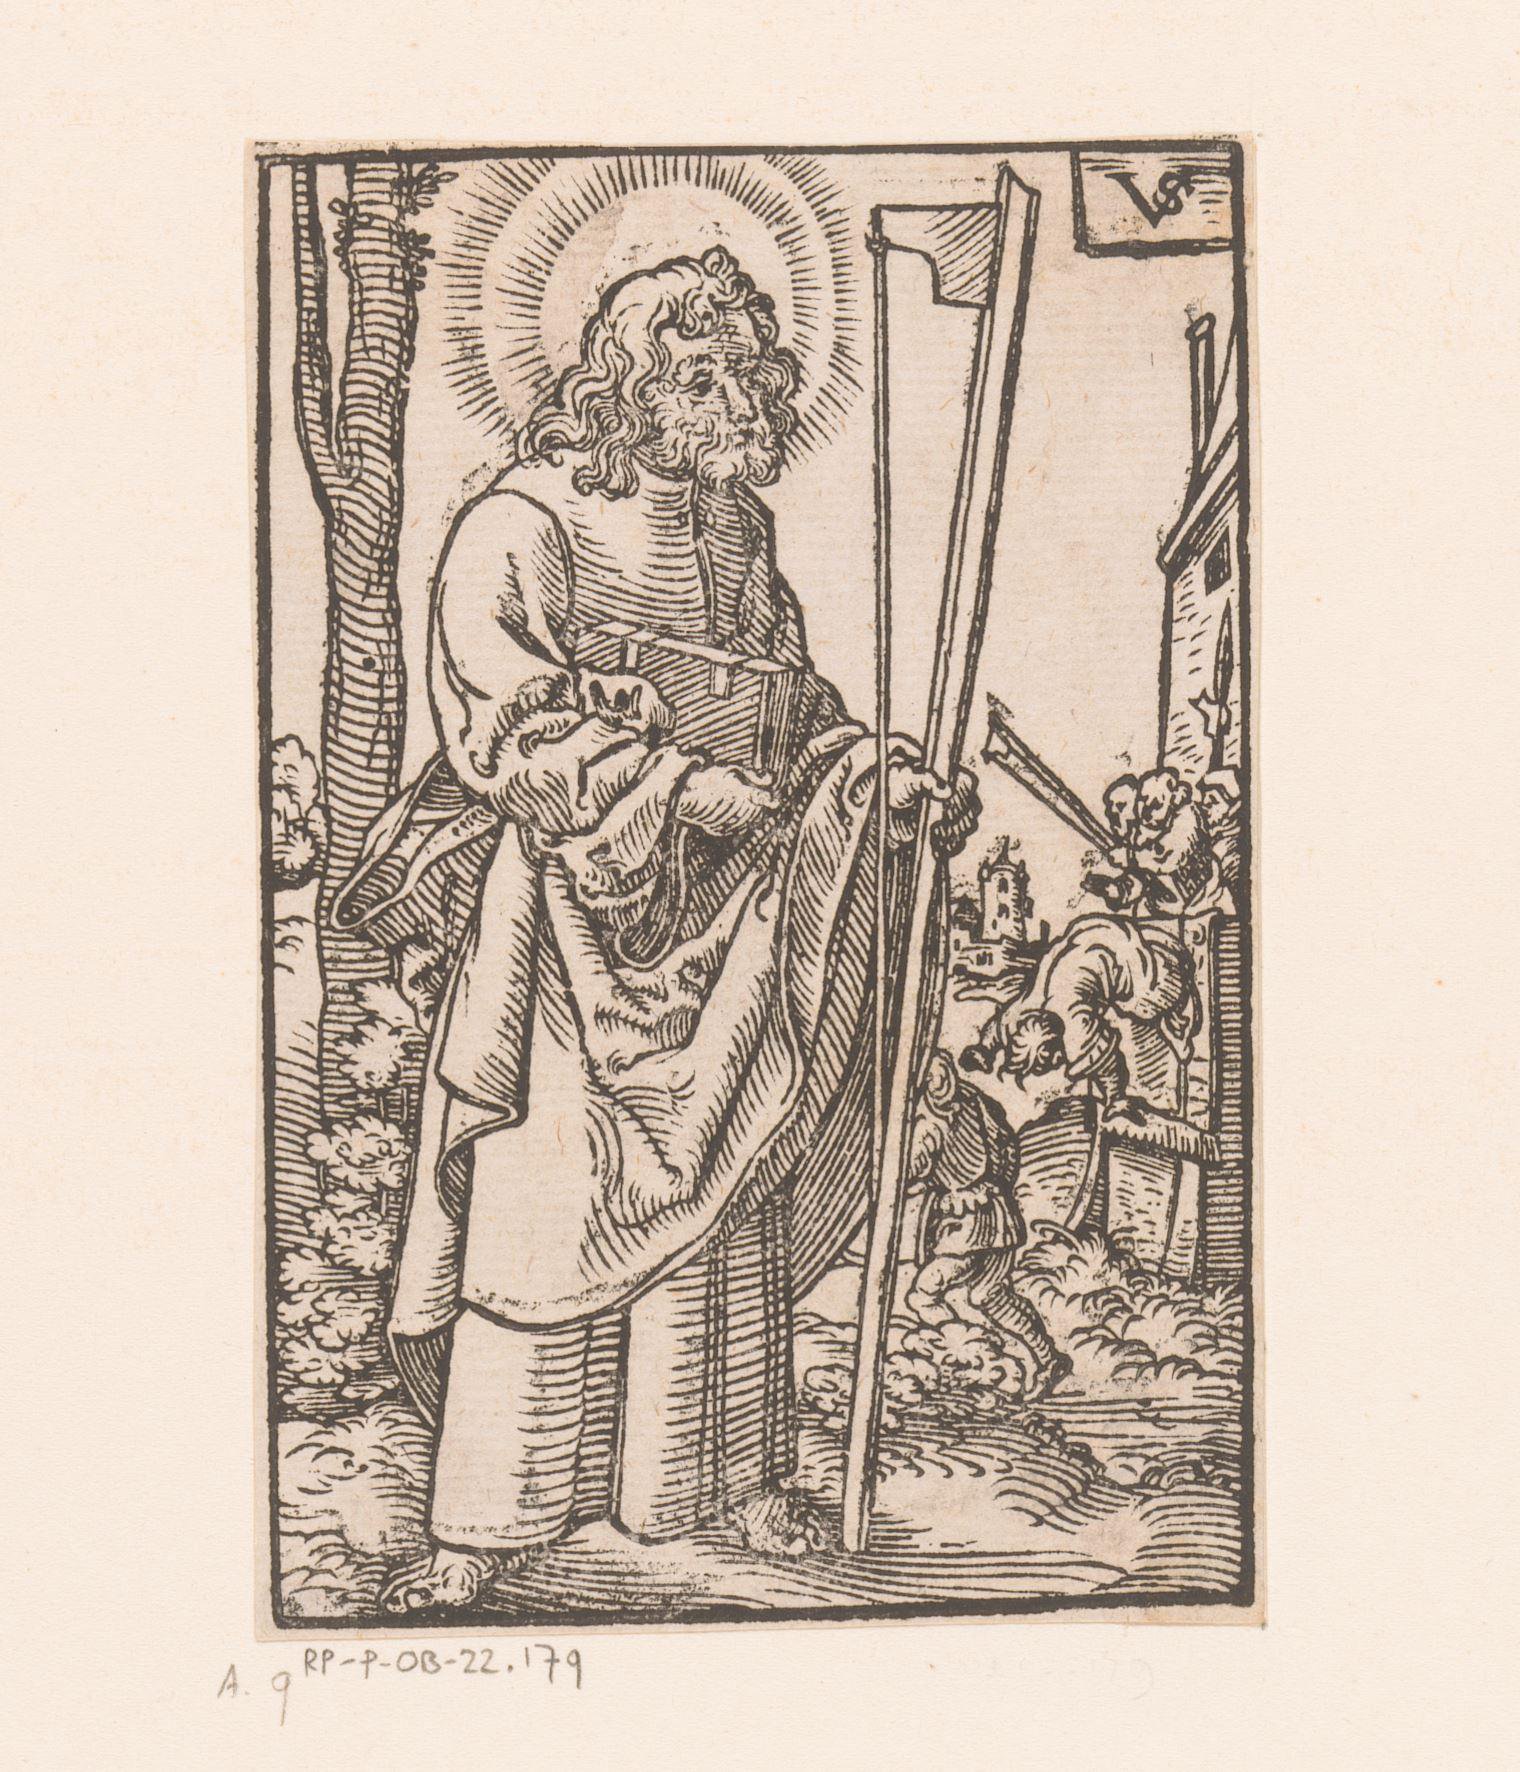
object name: book illustration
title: Heilige Jakobus de Mindere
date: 1552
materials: paper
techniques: woodcut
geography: nuremberg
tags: the apostle james the less, first bishop of jerusalem; possible attributes: book, fuller's club, scroll, james thrown from the roof of a temple in jerusalem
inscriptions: number: ‘182’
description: Gebruikt voor publicaties gedrukt door Valentin Geißler in 1552 en 1557 te Neurenberg.